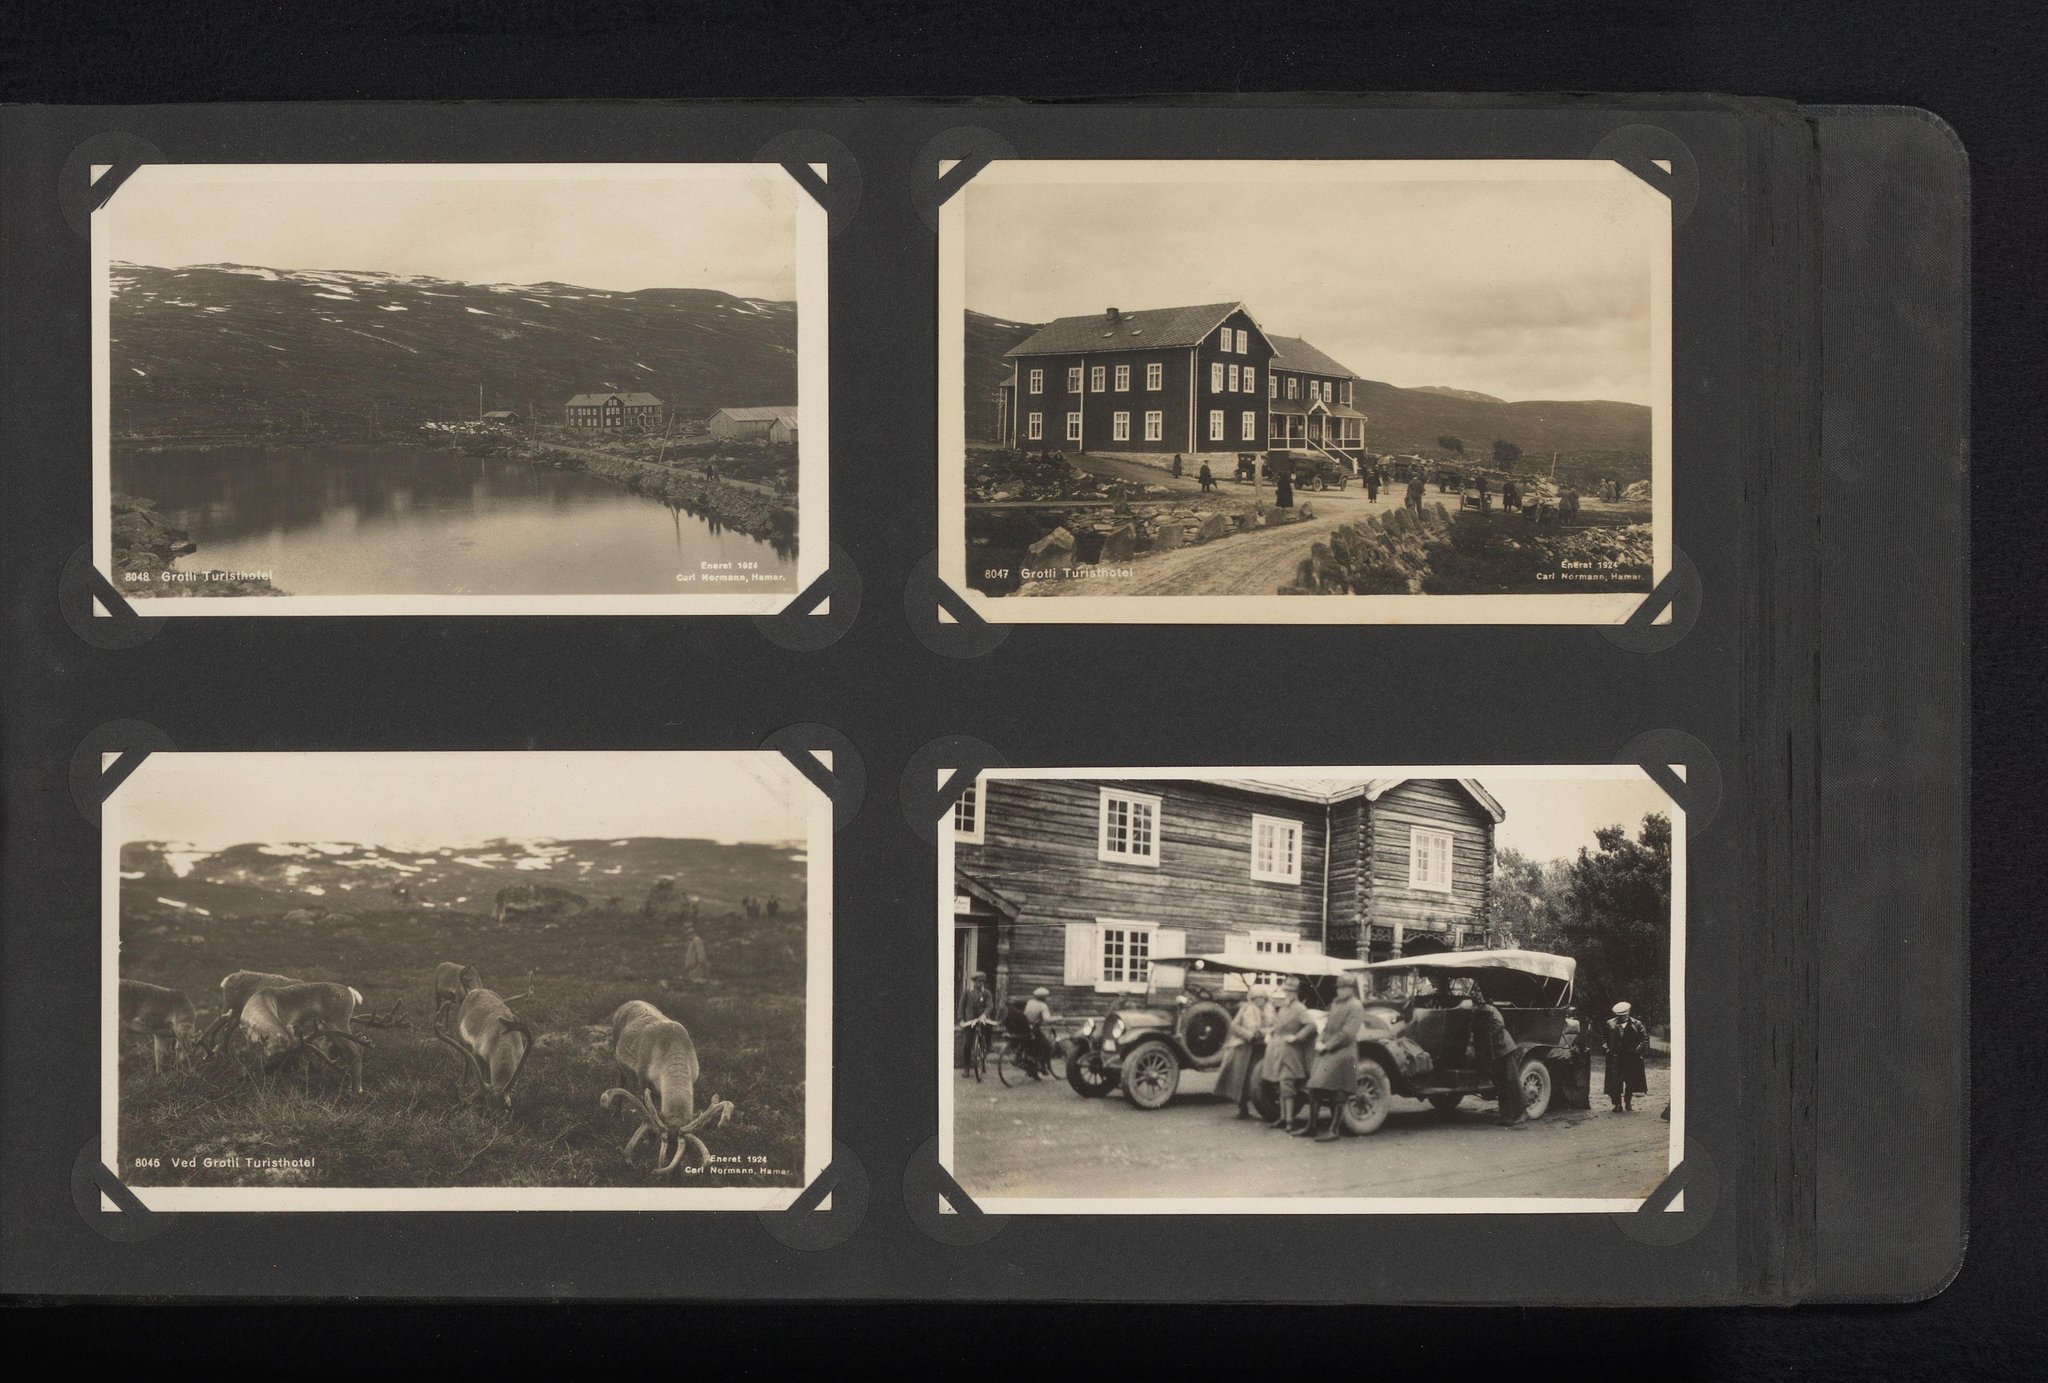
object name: photograph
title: Vier foto's, waarvan drie prentbriefkaarten, van Grotli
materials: paper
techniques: gelatin silver print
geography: grotli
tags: hoofed animals: deer, lake, automobile, hotel, hostelry, inn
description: Deze foto's maken deel uit van een album.